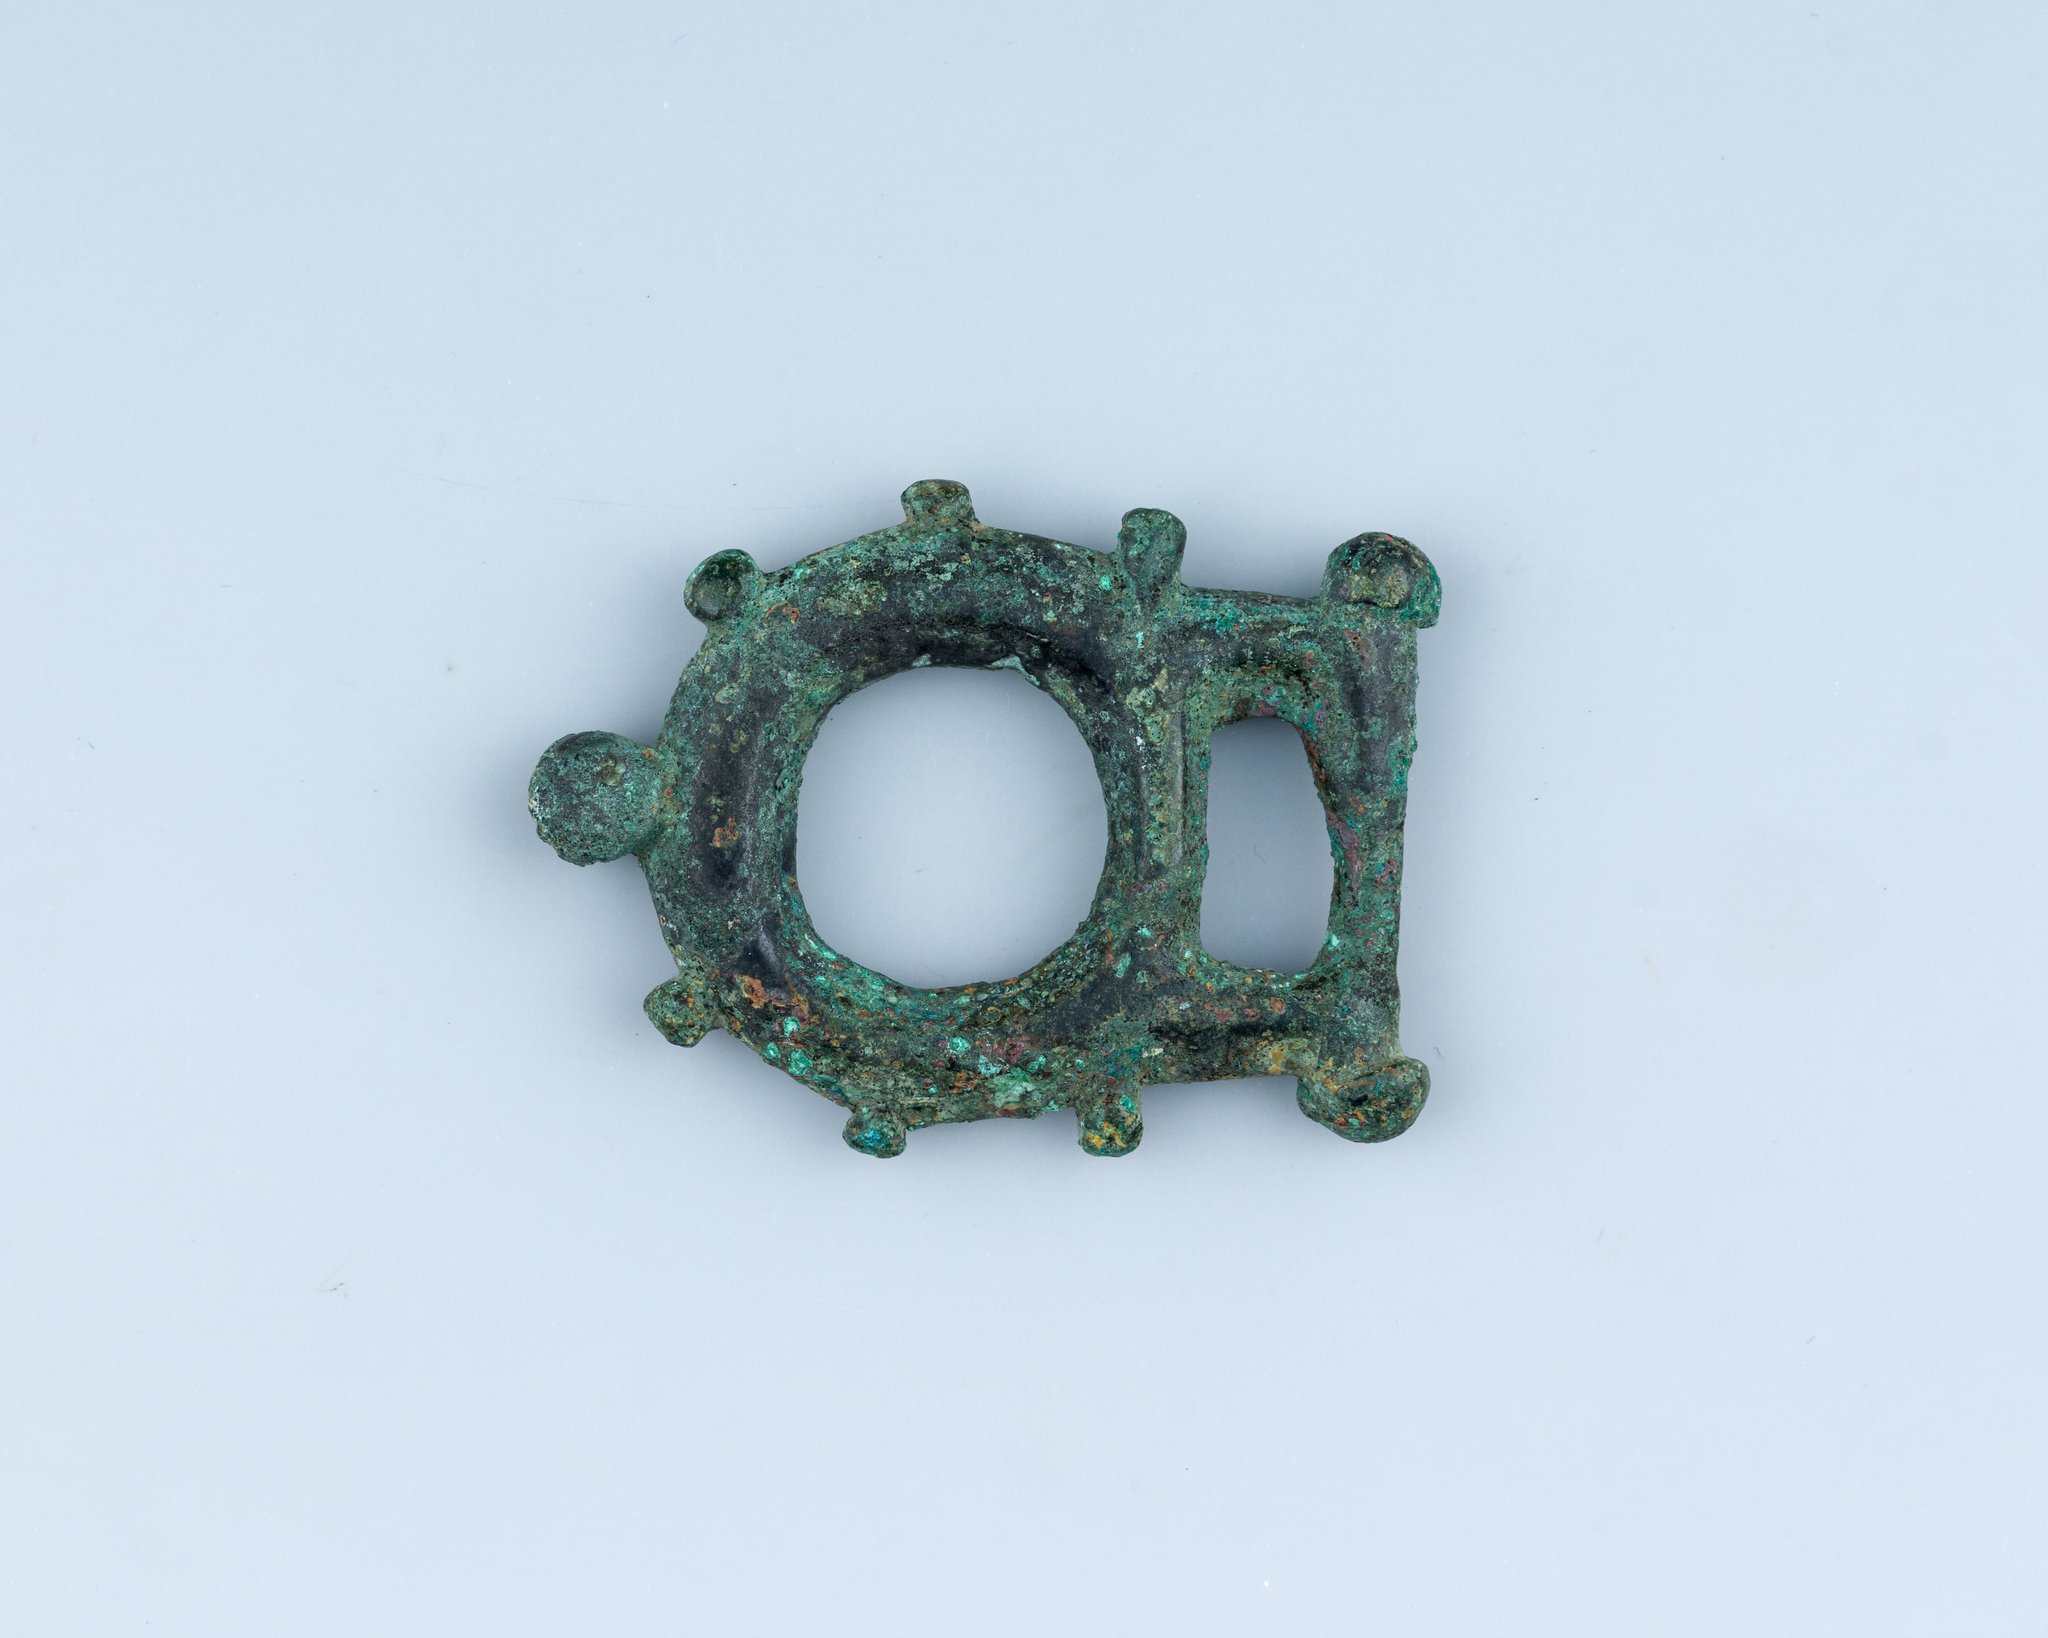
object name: buckle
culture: european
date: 1401-1700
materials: iron